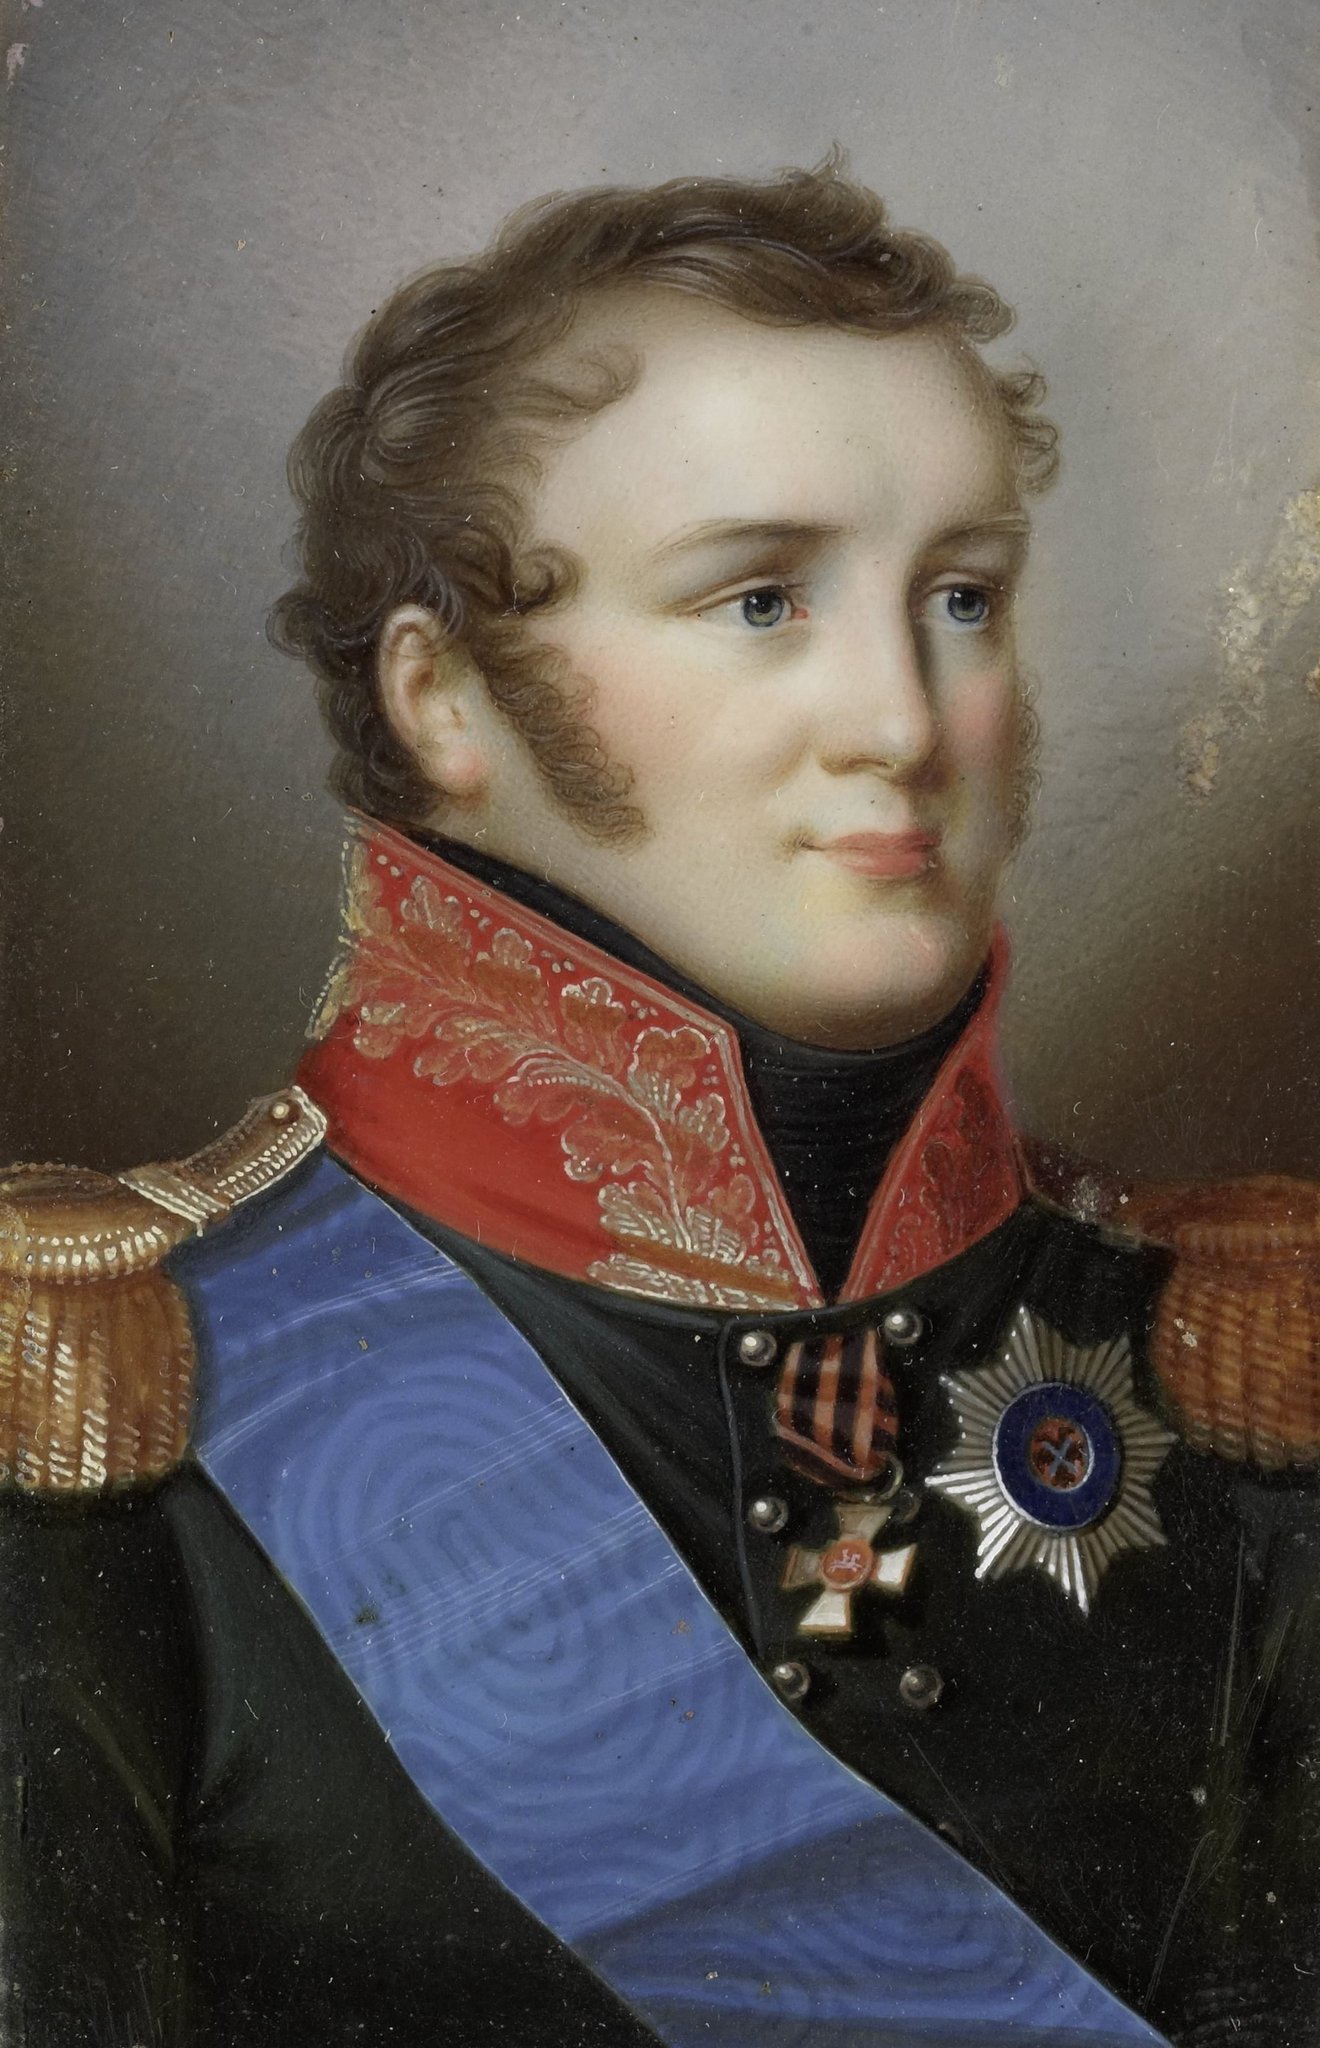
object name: painting, miniature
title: Portrait of Alexander I (1777-1825), Emperor of Russia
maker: domenico bossi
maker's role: painter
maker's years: 1767-1853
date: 1805-1815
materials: glass, ivory, metal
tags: alexander i (tsaar van rusland)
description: Attributed to Domenico Bossi (1765 - 1853). Alexander I (1777 - 1825), Emperor of Russia. After an original by Louise Bourdon (c. 1790 - c. 1810). Ivory.